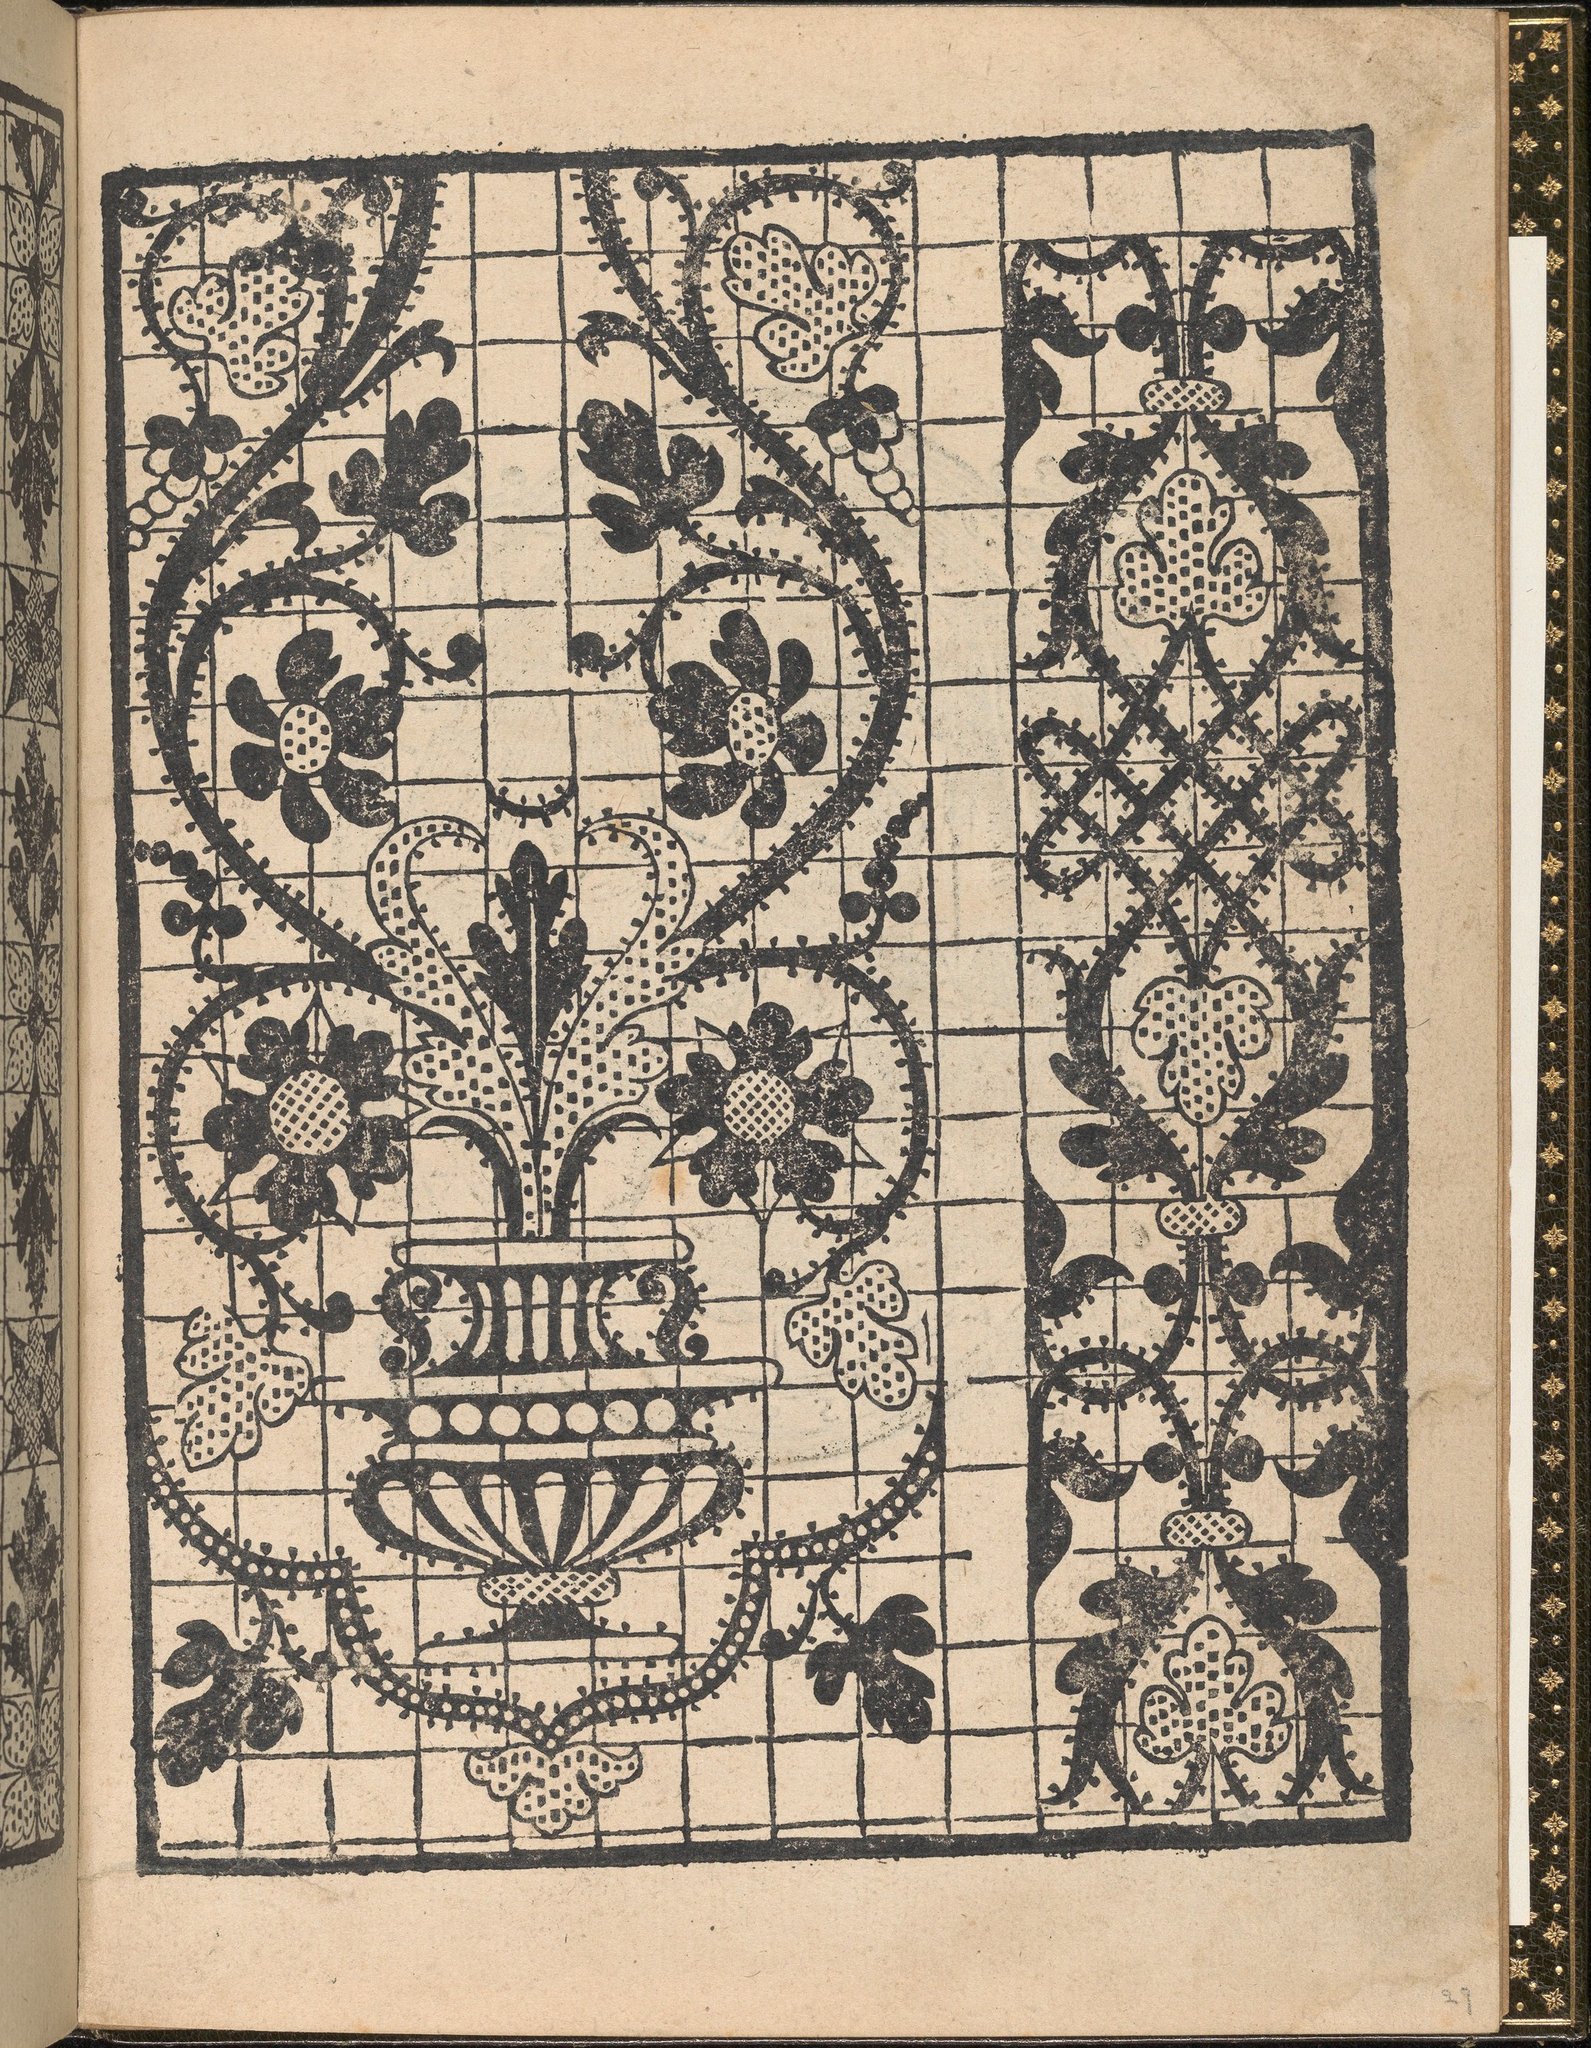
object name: book print ornament architecture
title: La Gloria et l'Honore di Ponti Tagliati, E Ponti in Aere, page 16 (recto)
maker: matteo pagano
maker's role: publisher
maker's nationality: italian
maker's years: 1515-1588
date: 1556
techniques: woodcut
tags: flowers